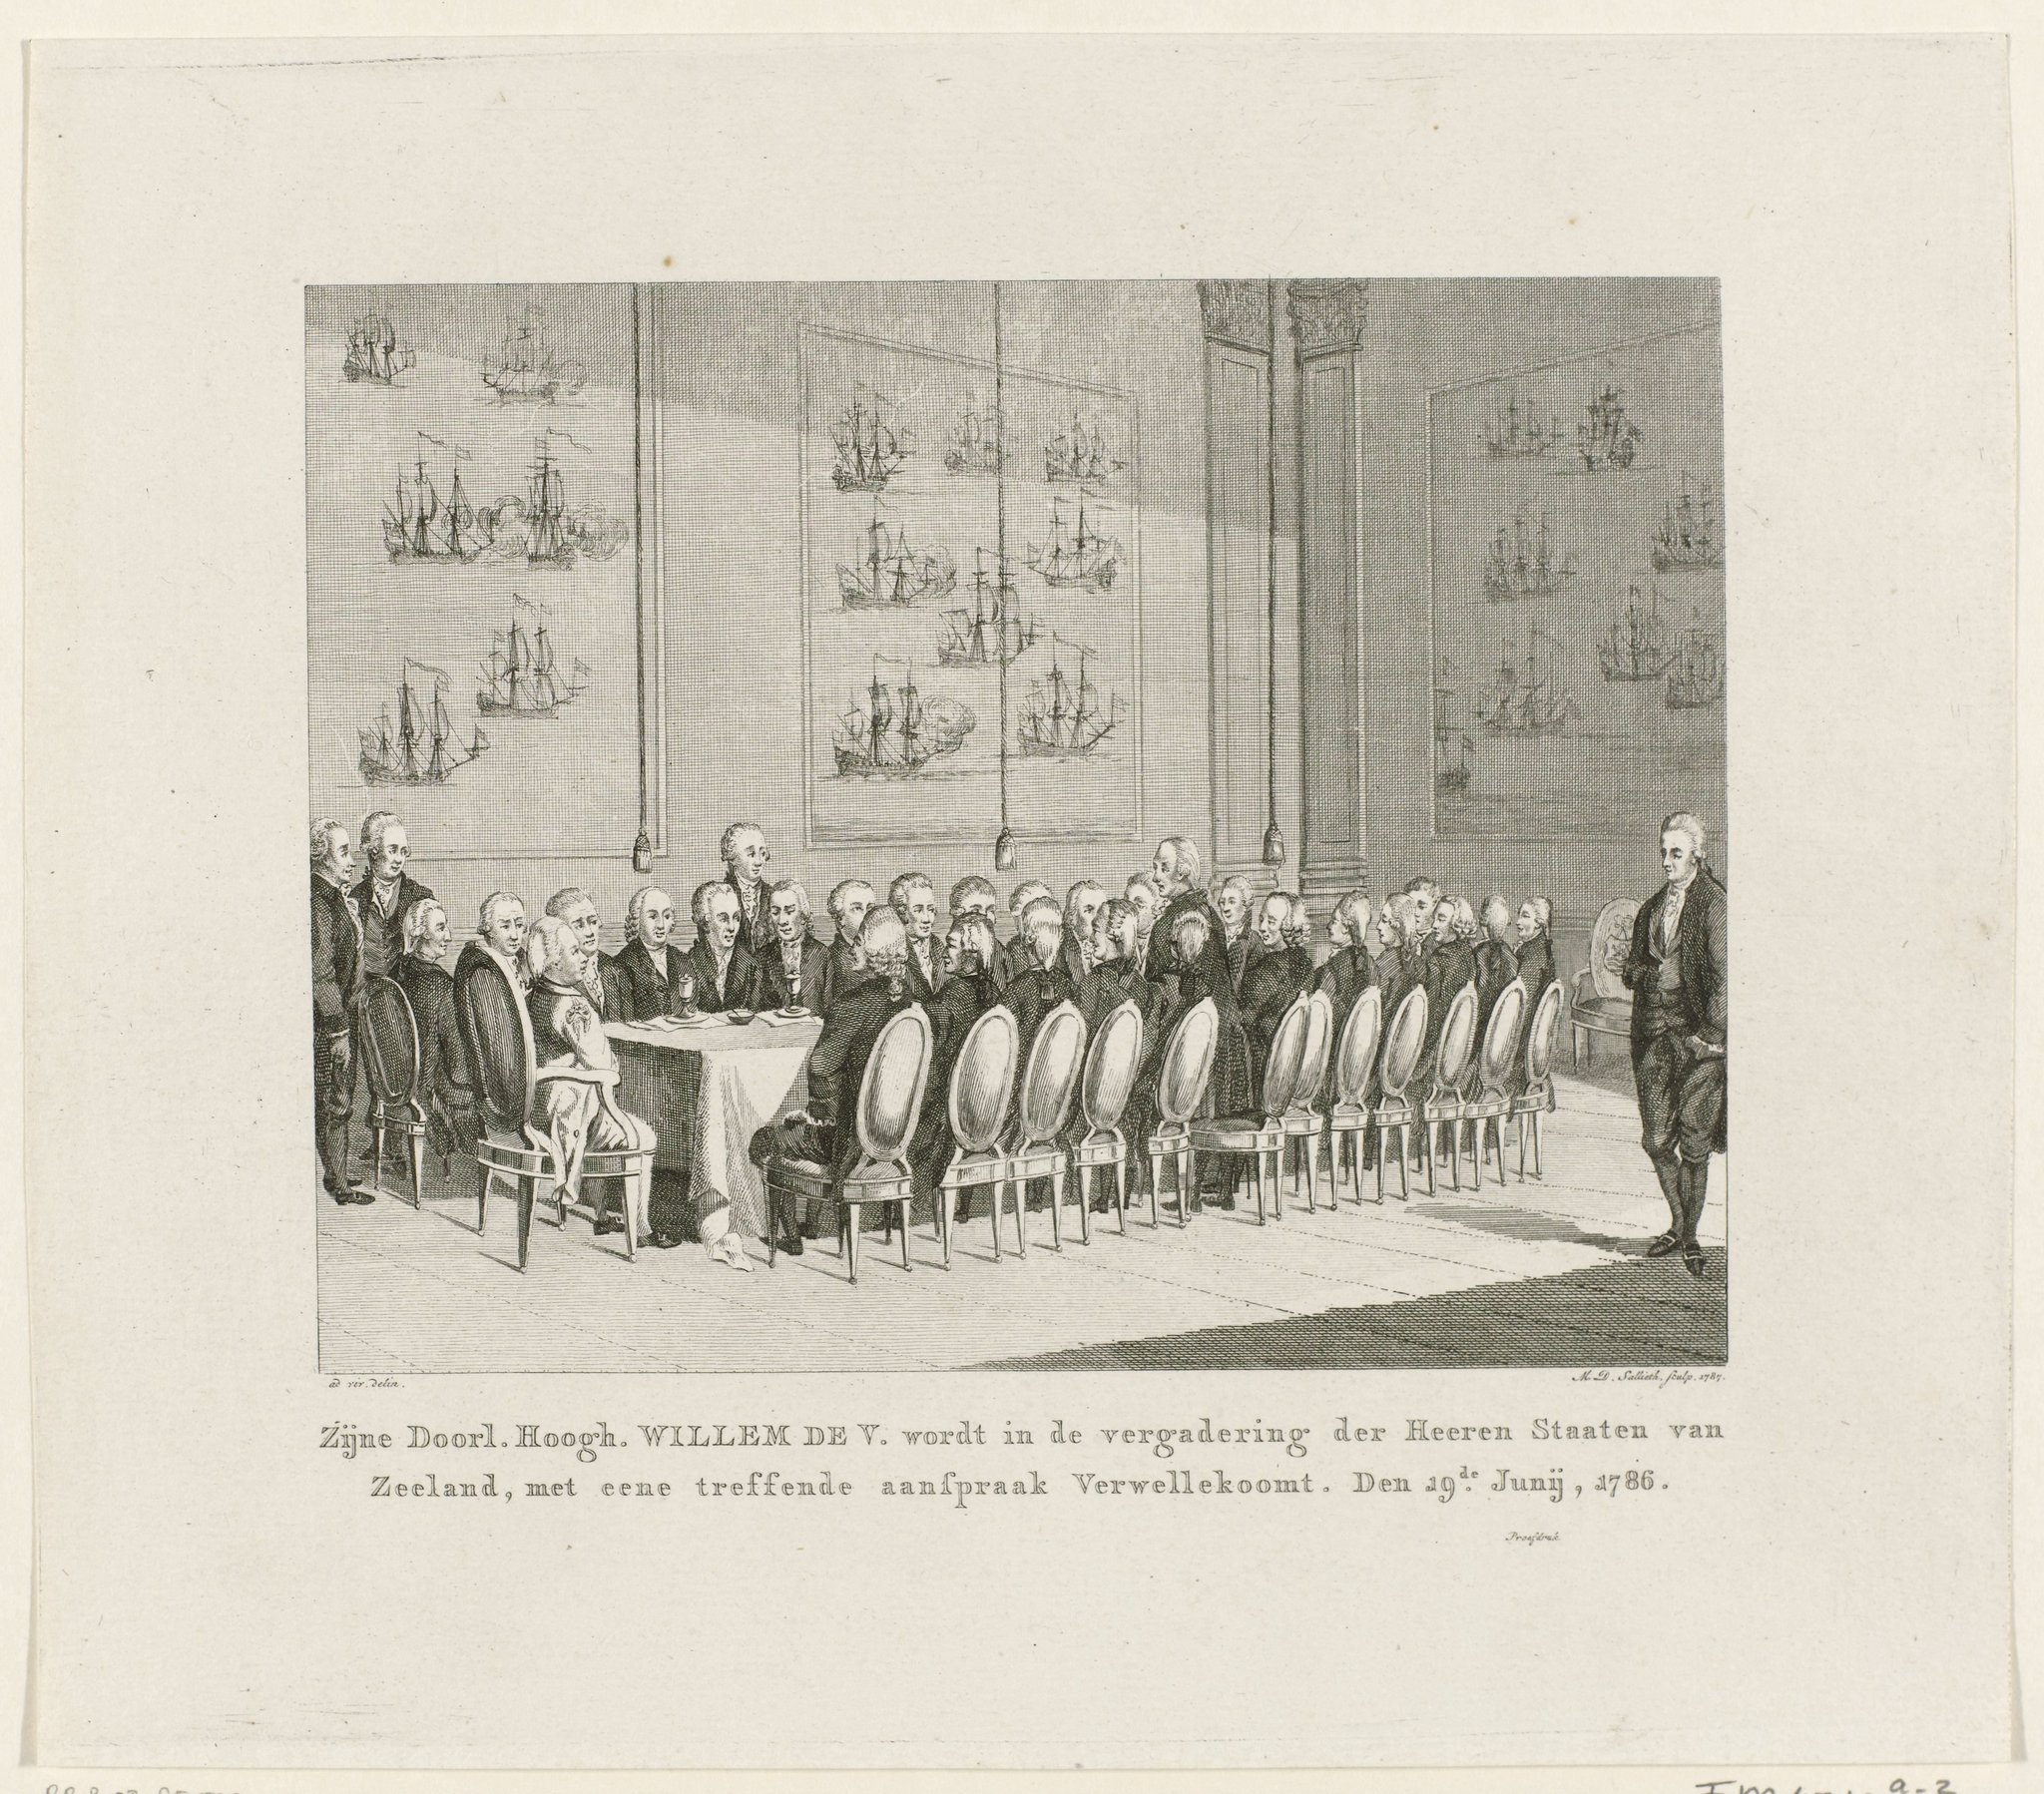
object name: print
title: Willem V toegesproken in de vergadering van de Staten van Zeeland, 1786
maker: mathias de sallieth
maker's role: print maker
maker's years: 1749-1791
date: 1787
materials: paper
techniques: engraving, etching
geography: zeeland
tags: the hague, william v (prince of orange), public festivities on the occasion of royal events, provincial government, middelburg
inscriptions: collector's mark: Lugt 2228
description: Prins Willem V wordt ontvangen en toegesproken in de vergadering van de Staten van Zeeland te Middelburg op 19 juni 1786. Aan de wanden hangen tapijten met zeeslagen. Illustraties van het bezoek van de prins en prinses aan Zeeland 18 juni - 25 juli 1786.